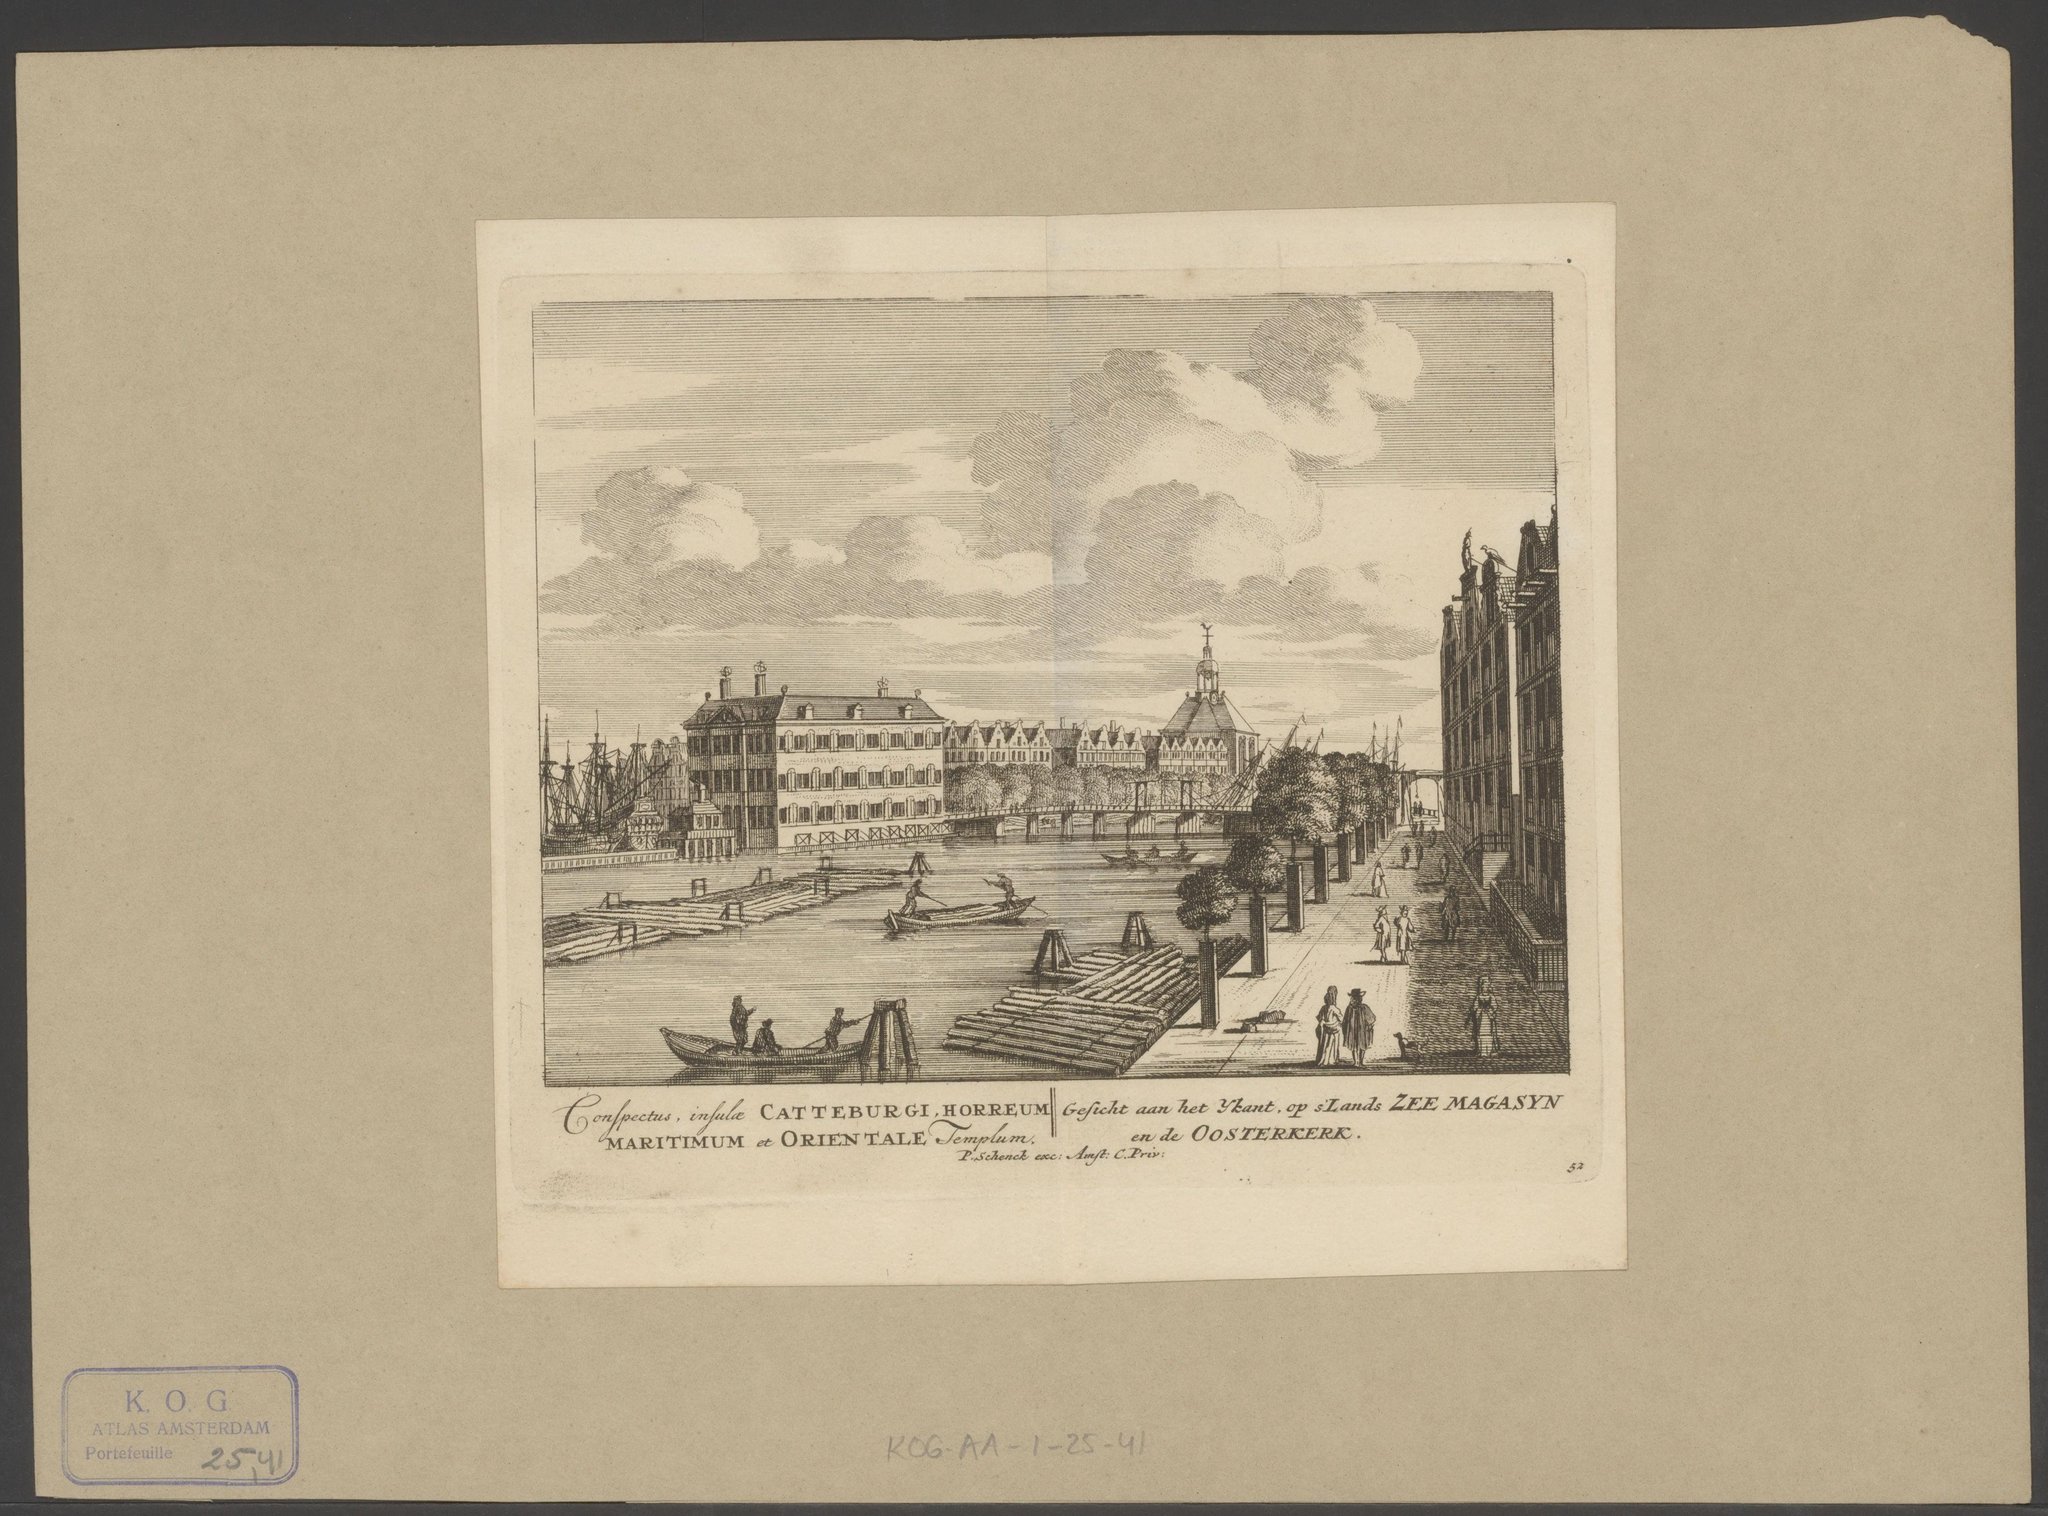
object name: book illustration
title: 100 Afbeeldinge der voornaamste gebouwen van Amsterdam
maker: Anonymous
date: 1710-1711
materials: paper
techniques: engraving, etching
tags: large-scale structure for storage, e.g.: warehouse, depot, silo, bridge in city across river, canal, etc. (+ city(-scape) with figures, staffage), church (exterior), ammunition store, arsenal, street (+ city(-scape) with figures, staffage)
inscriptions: collector's mark: ‘25.41’ Lugt 1641b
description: Huidige staat van prent ook gebruikt in: 100 Afbeeldinge der voornaamste gebouwen van Amsterdam. Amsterdam, Pieter Schenk (I), s.a. [1710-1711]. En in: 100 Afbeeldinge der voornaamste gebouwen van Amsterdam. Amsterdam: Barent Greve, [1757-1766].* *In de tweede uitgave, uitgegeven door Barent Greve, is alleen de titelprent aangepast. De overige prenten zijn onveranderd gebleven.